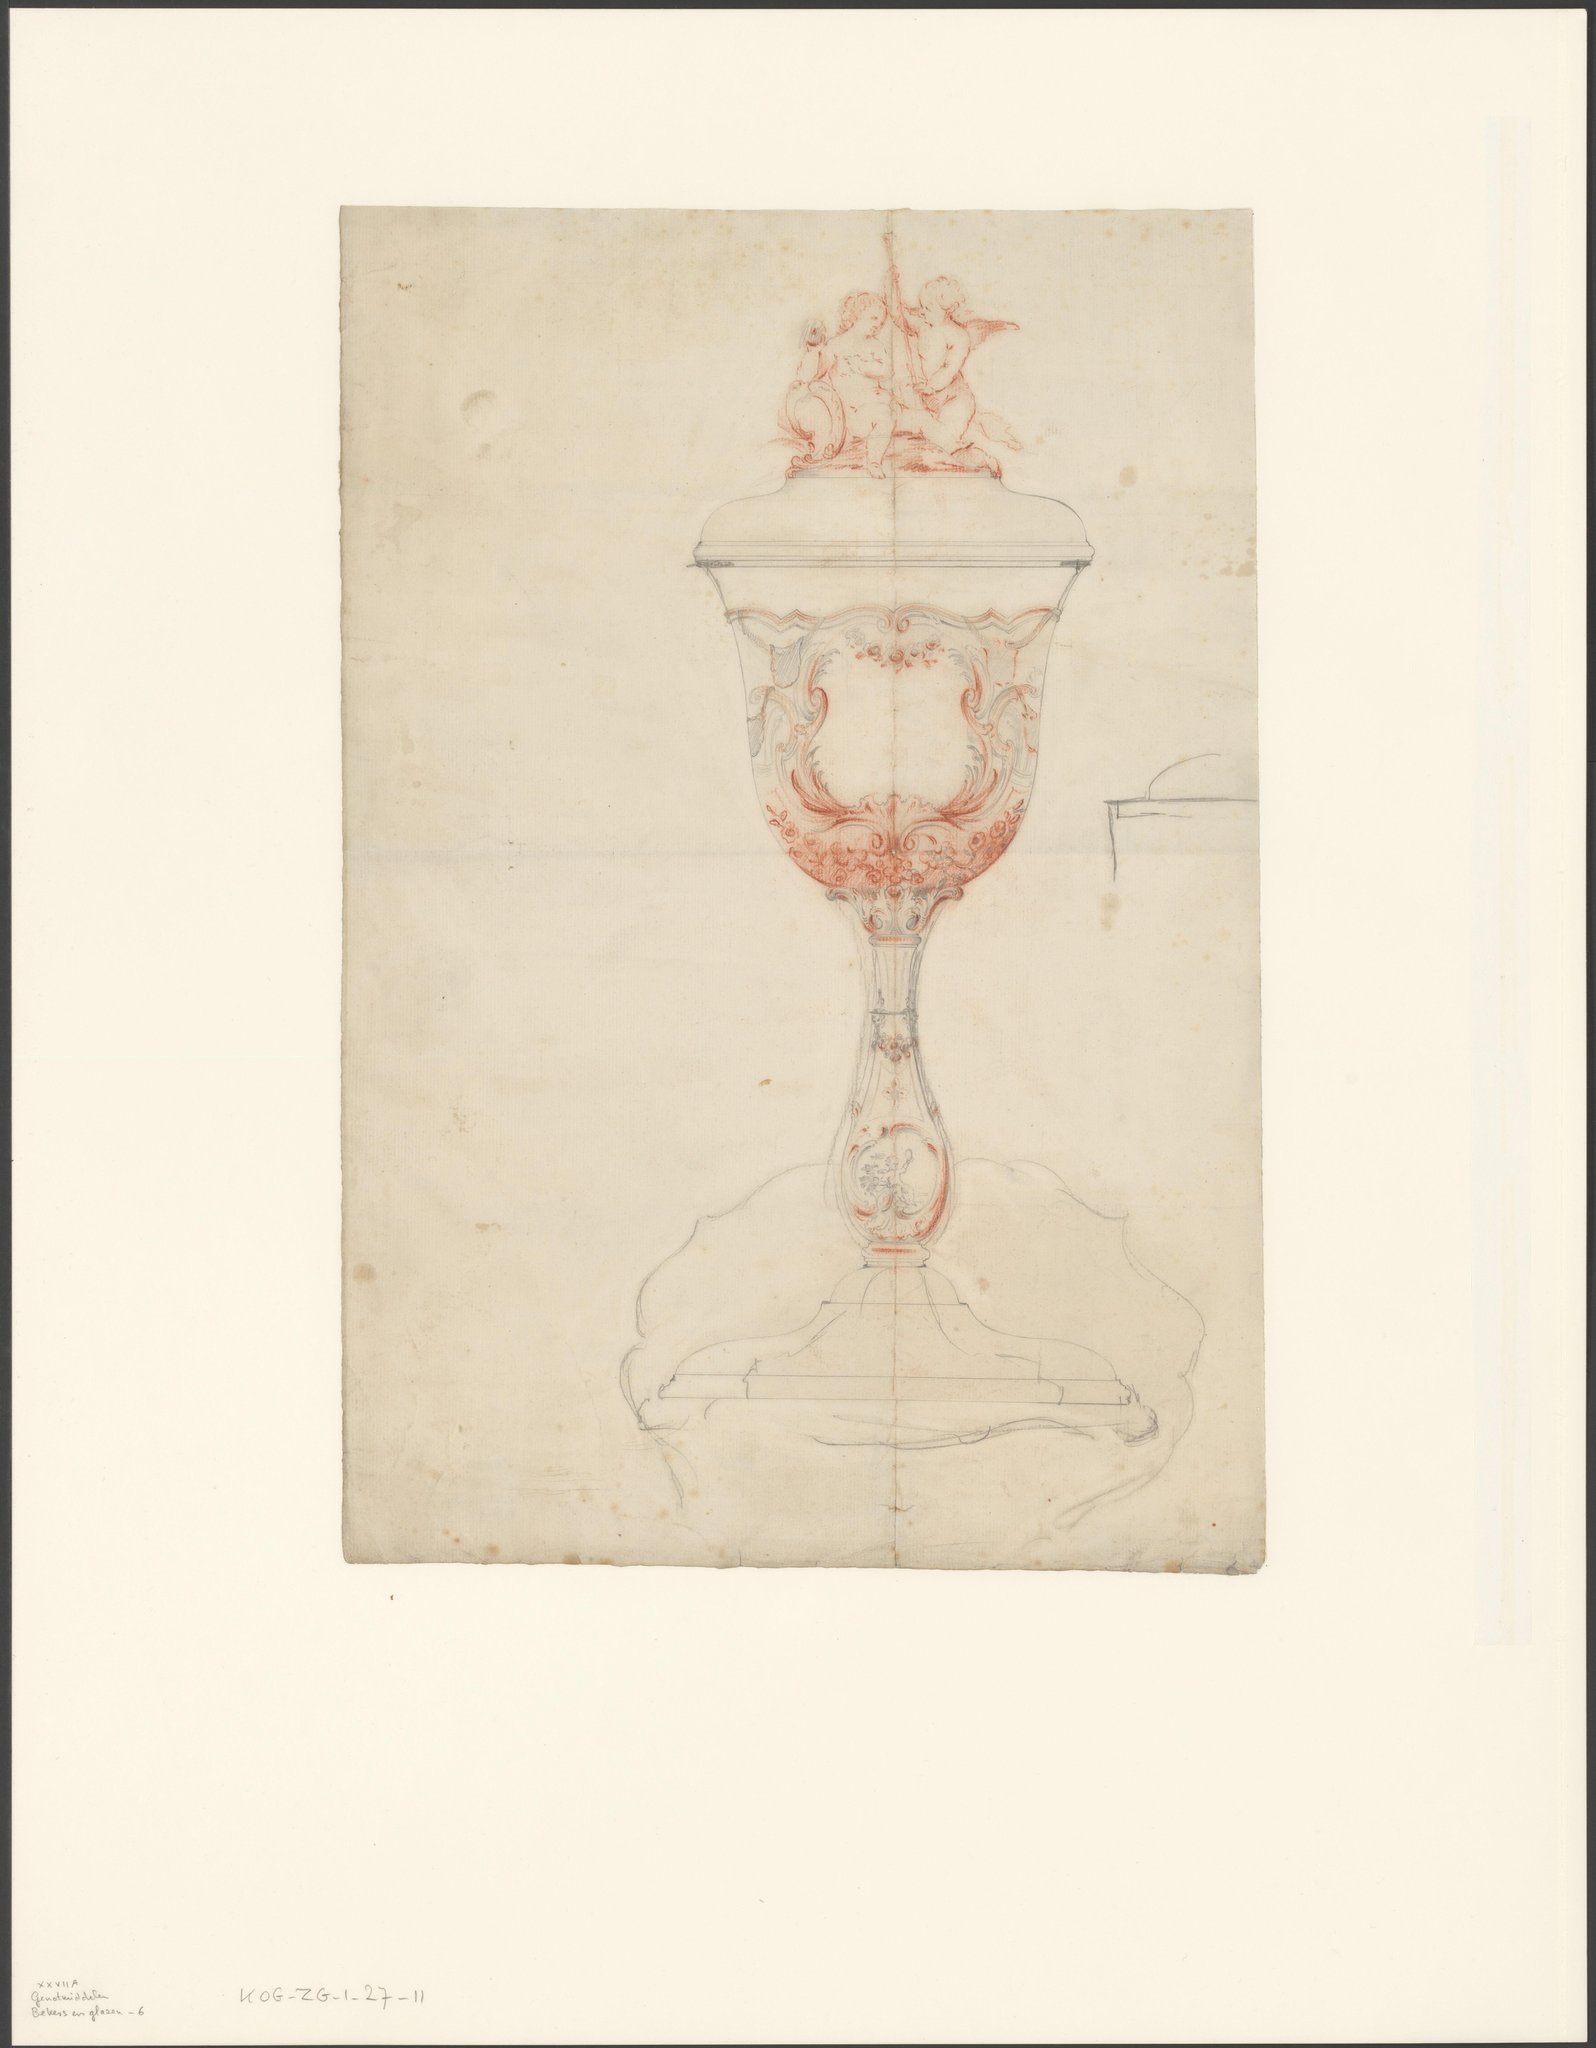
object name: drawing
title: Ontwerp voor een zilveren bokaal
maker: Anonymous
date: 1750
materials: chalk, paper, pencil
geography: netherlands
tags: cup, alcoholic drinks